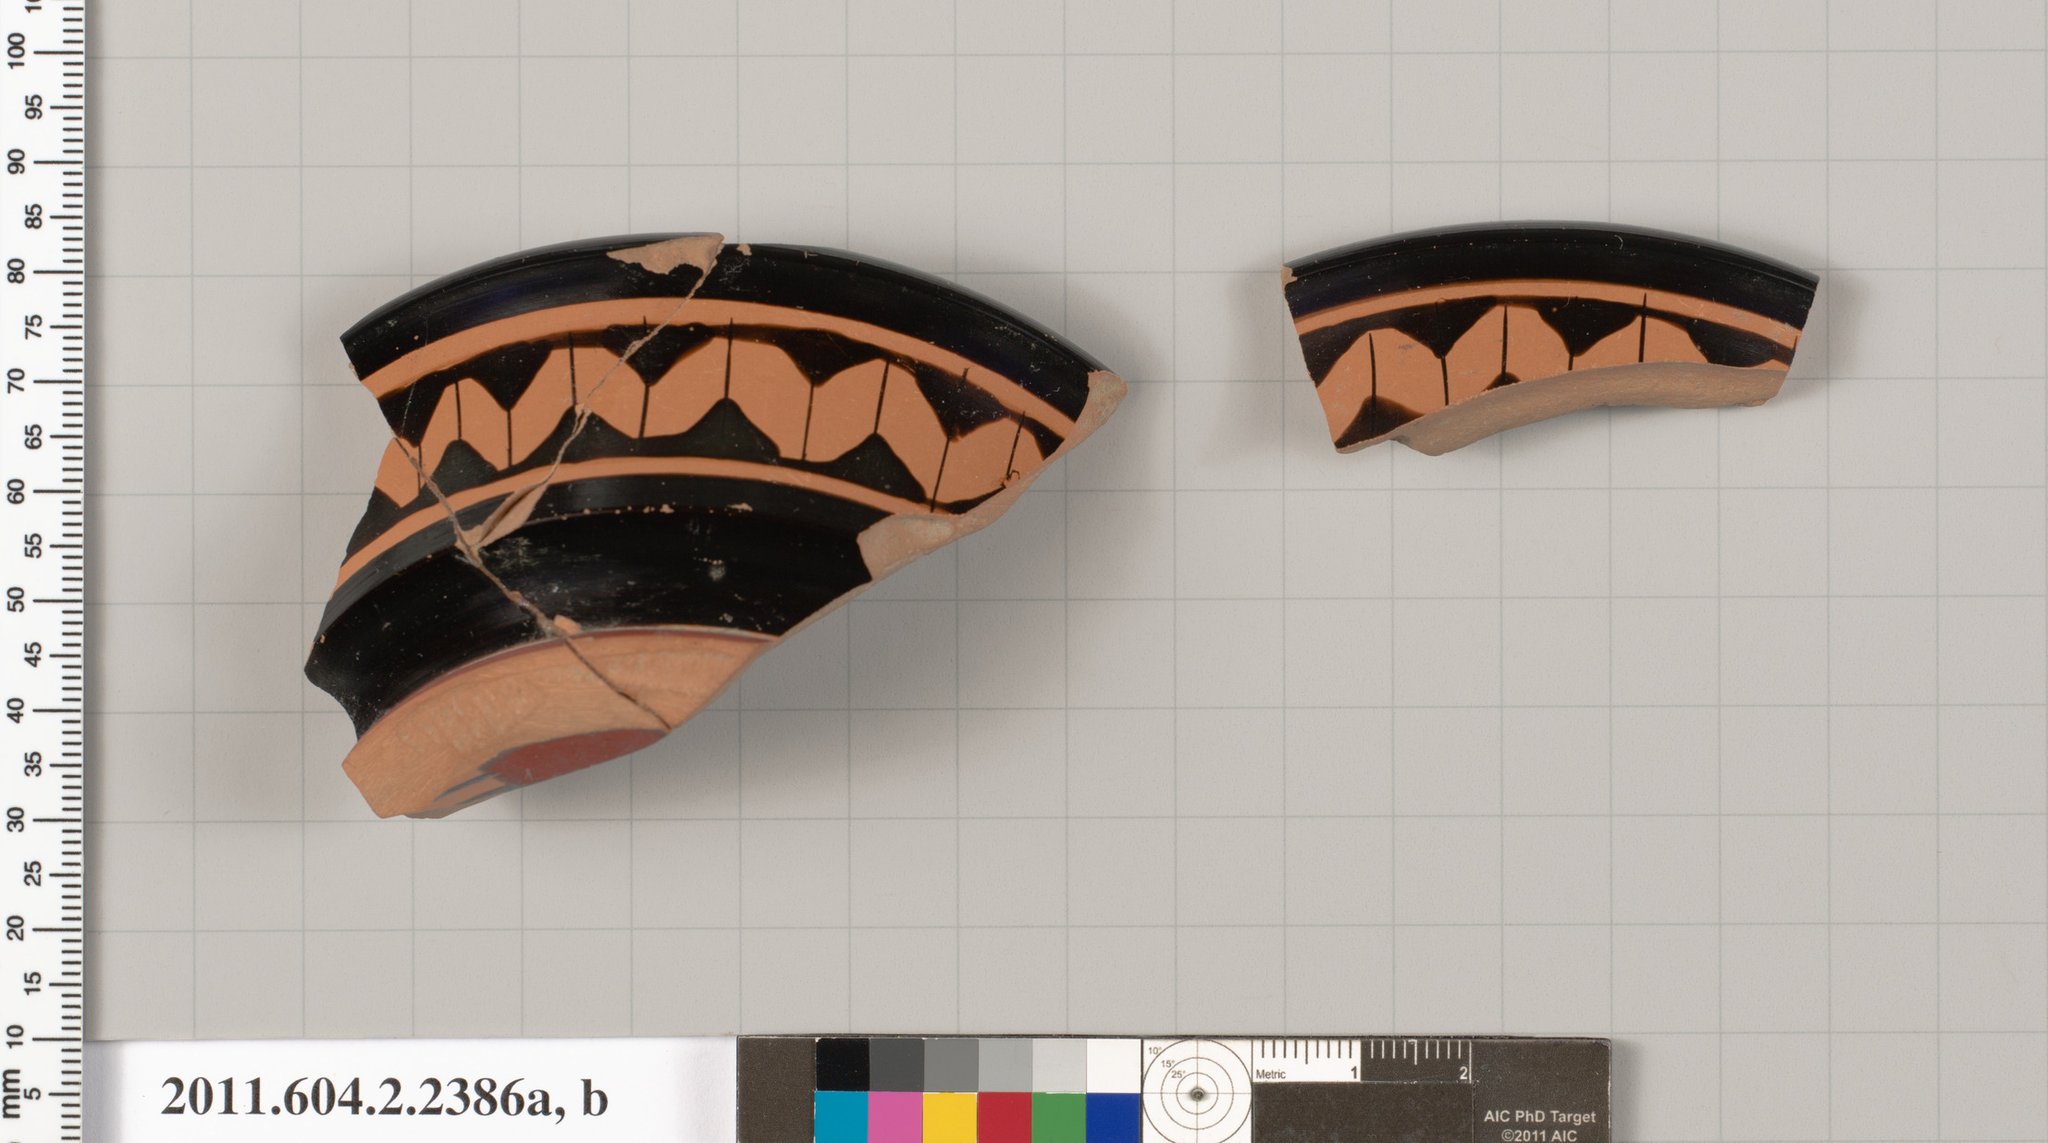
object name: pyxis fragment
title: Terracotta fragments of a Nicosthenic pyxis (box)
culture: greek, attic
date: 534-468 BCE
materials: terracotta